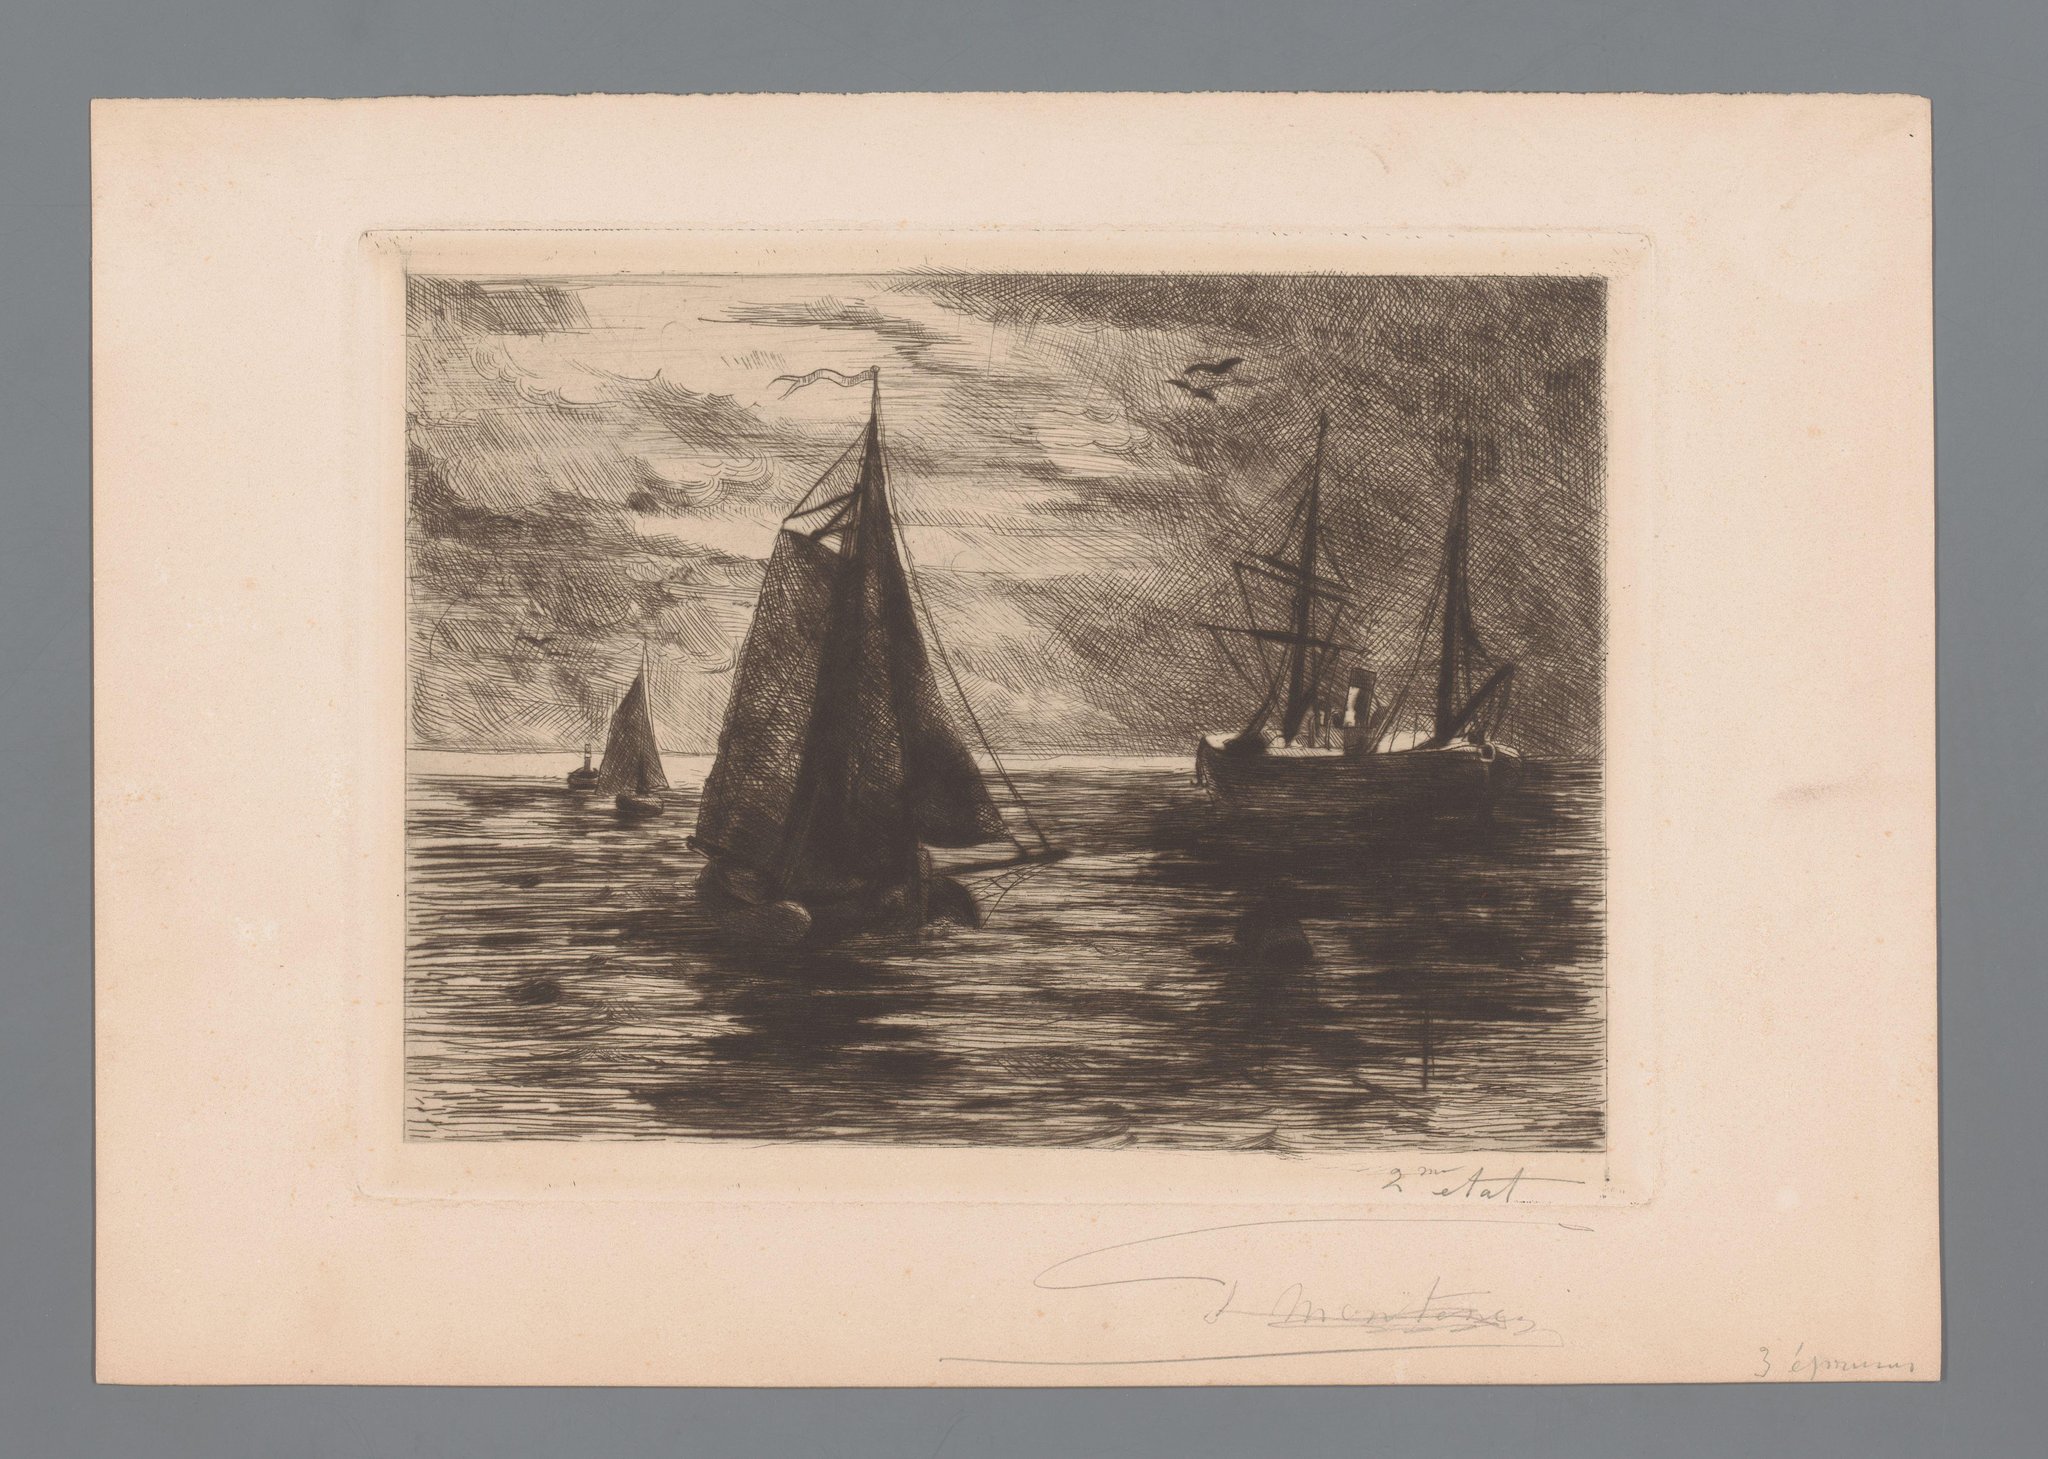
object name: print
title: Schepen op het water bij het vallen van de avond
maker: georges montenez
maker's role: print maker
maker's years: 1873-1930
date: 1883-1913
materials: paper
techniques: drypoint, etching, intaglio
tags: sailing-ship, sailing-boat, landscapes with waters, waterscapes, seascapes (in the temperate zone)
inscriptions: inscription: ‘2m etat’, collector's mark: Lugt 2228